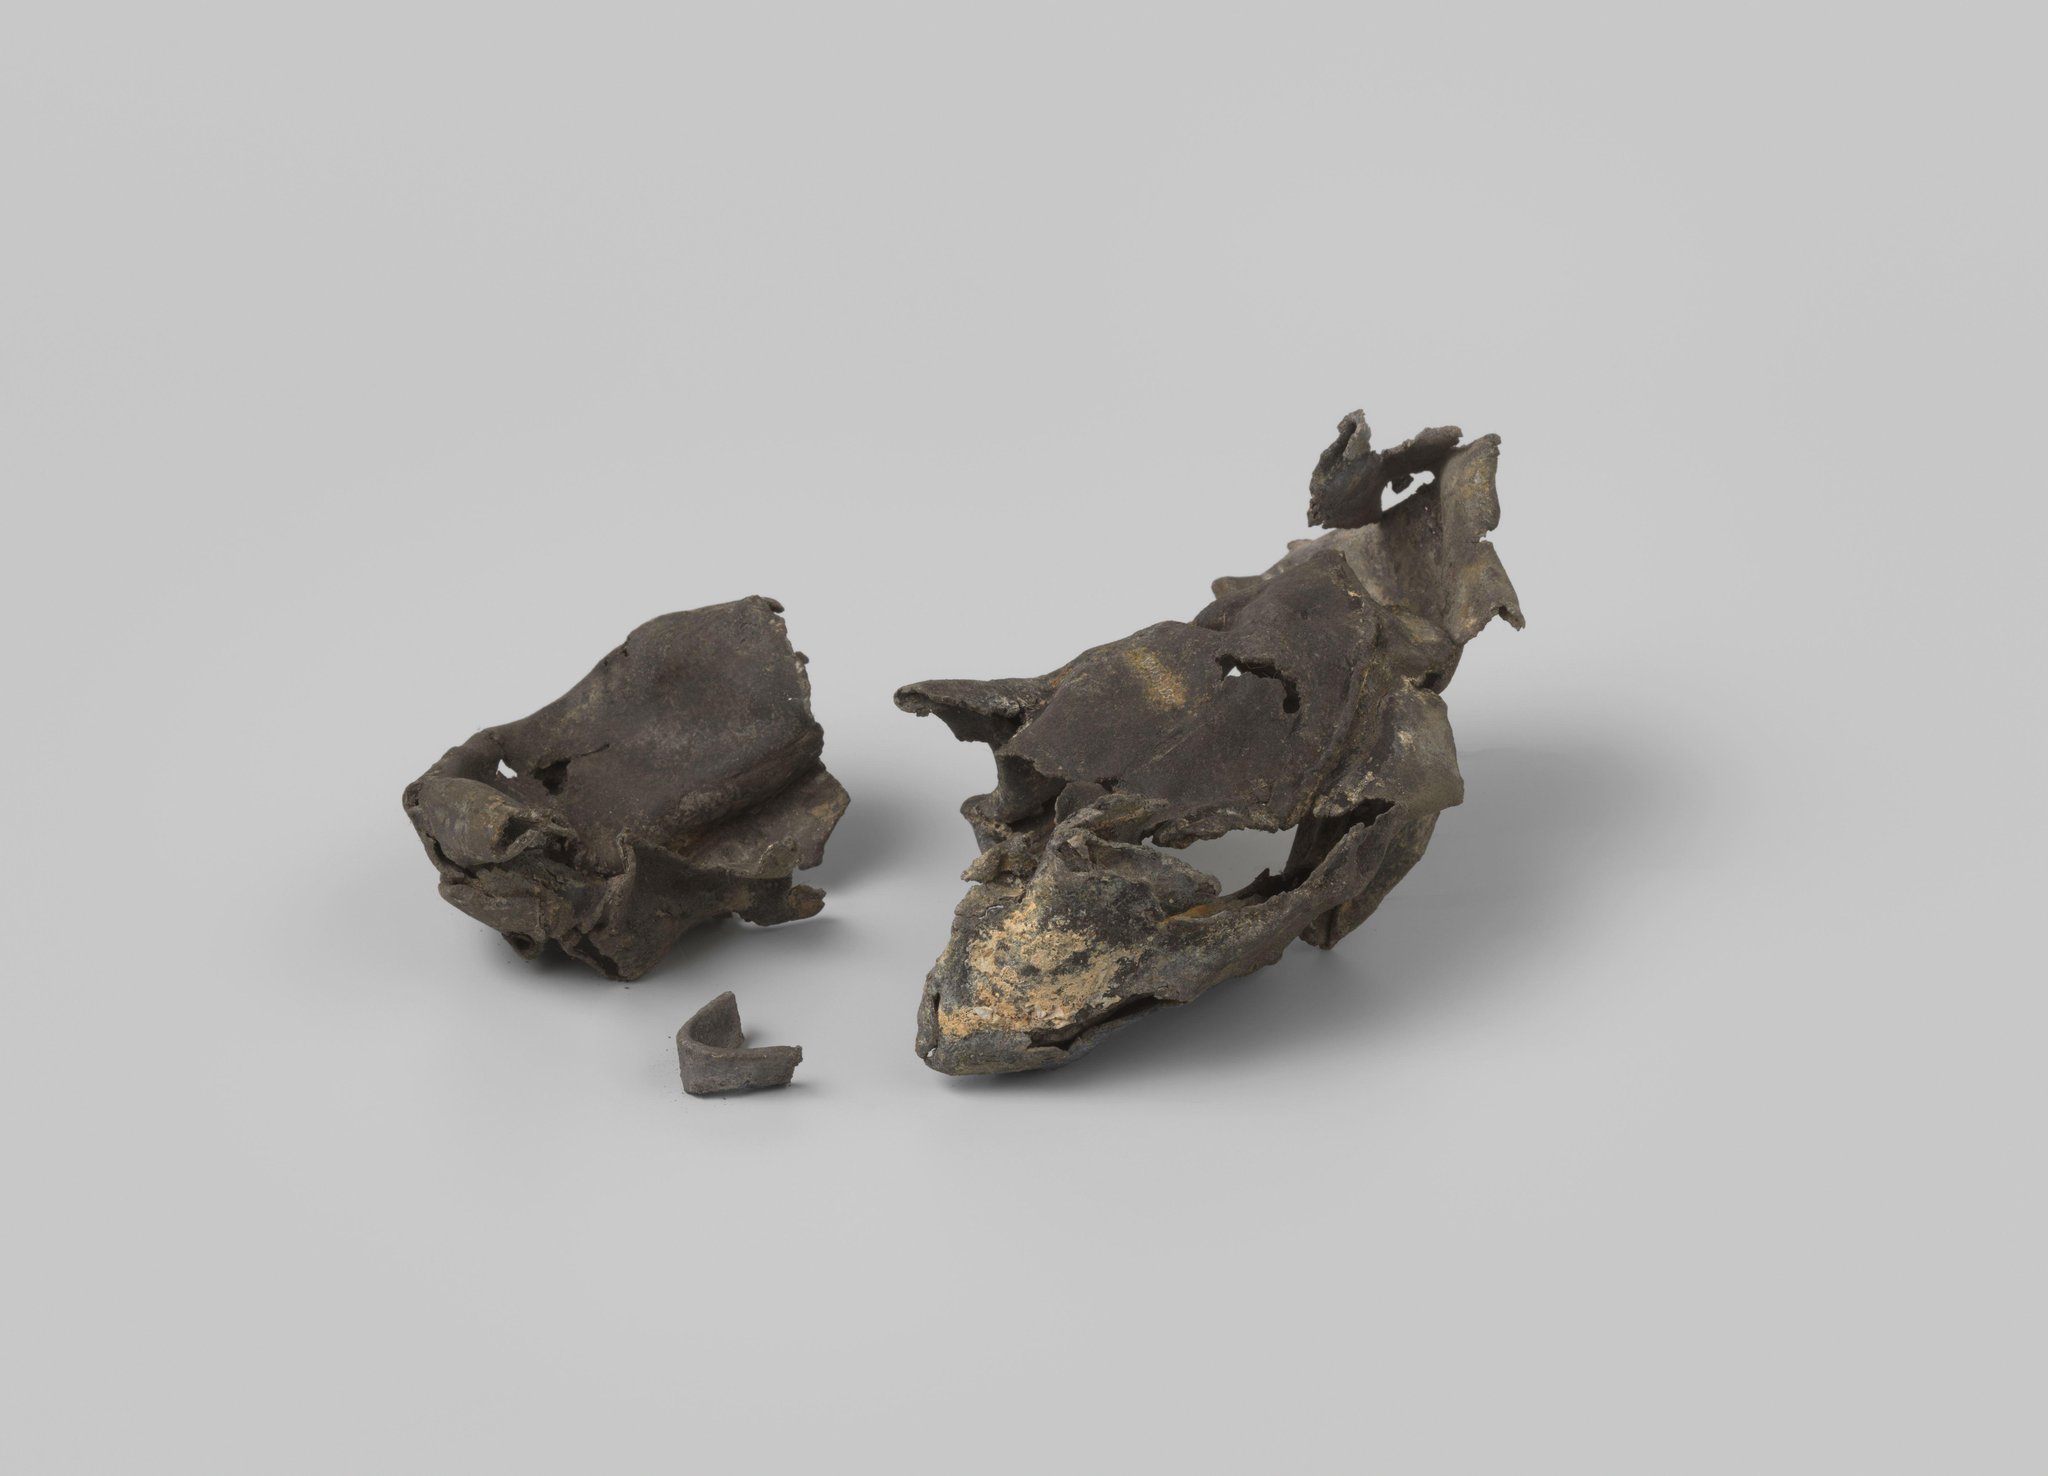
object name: chamber pot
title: Fragmenten po uit het wrak van de Oost-Indiëvaarder Hollandia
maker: Anonymous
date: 1700-1743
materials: tin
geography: netherlands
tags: verenigde oostindische compagnie, hollandia (schip), annet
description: Container, chamber pot; fragm of rim and base, id. NG 1980-27H3210, squashed.